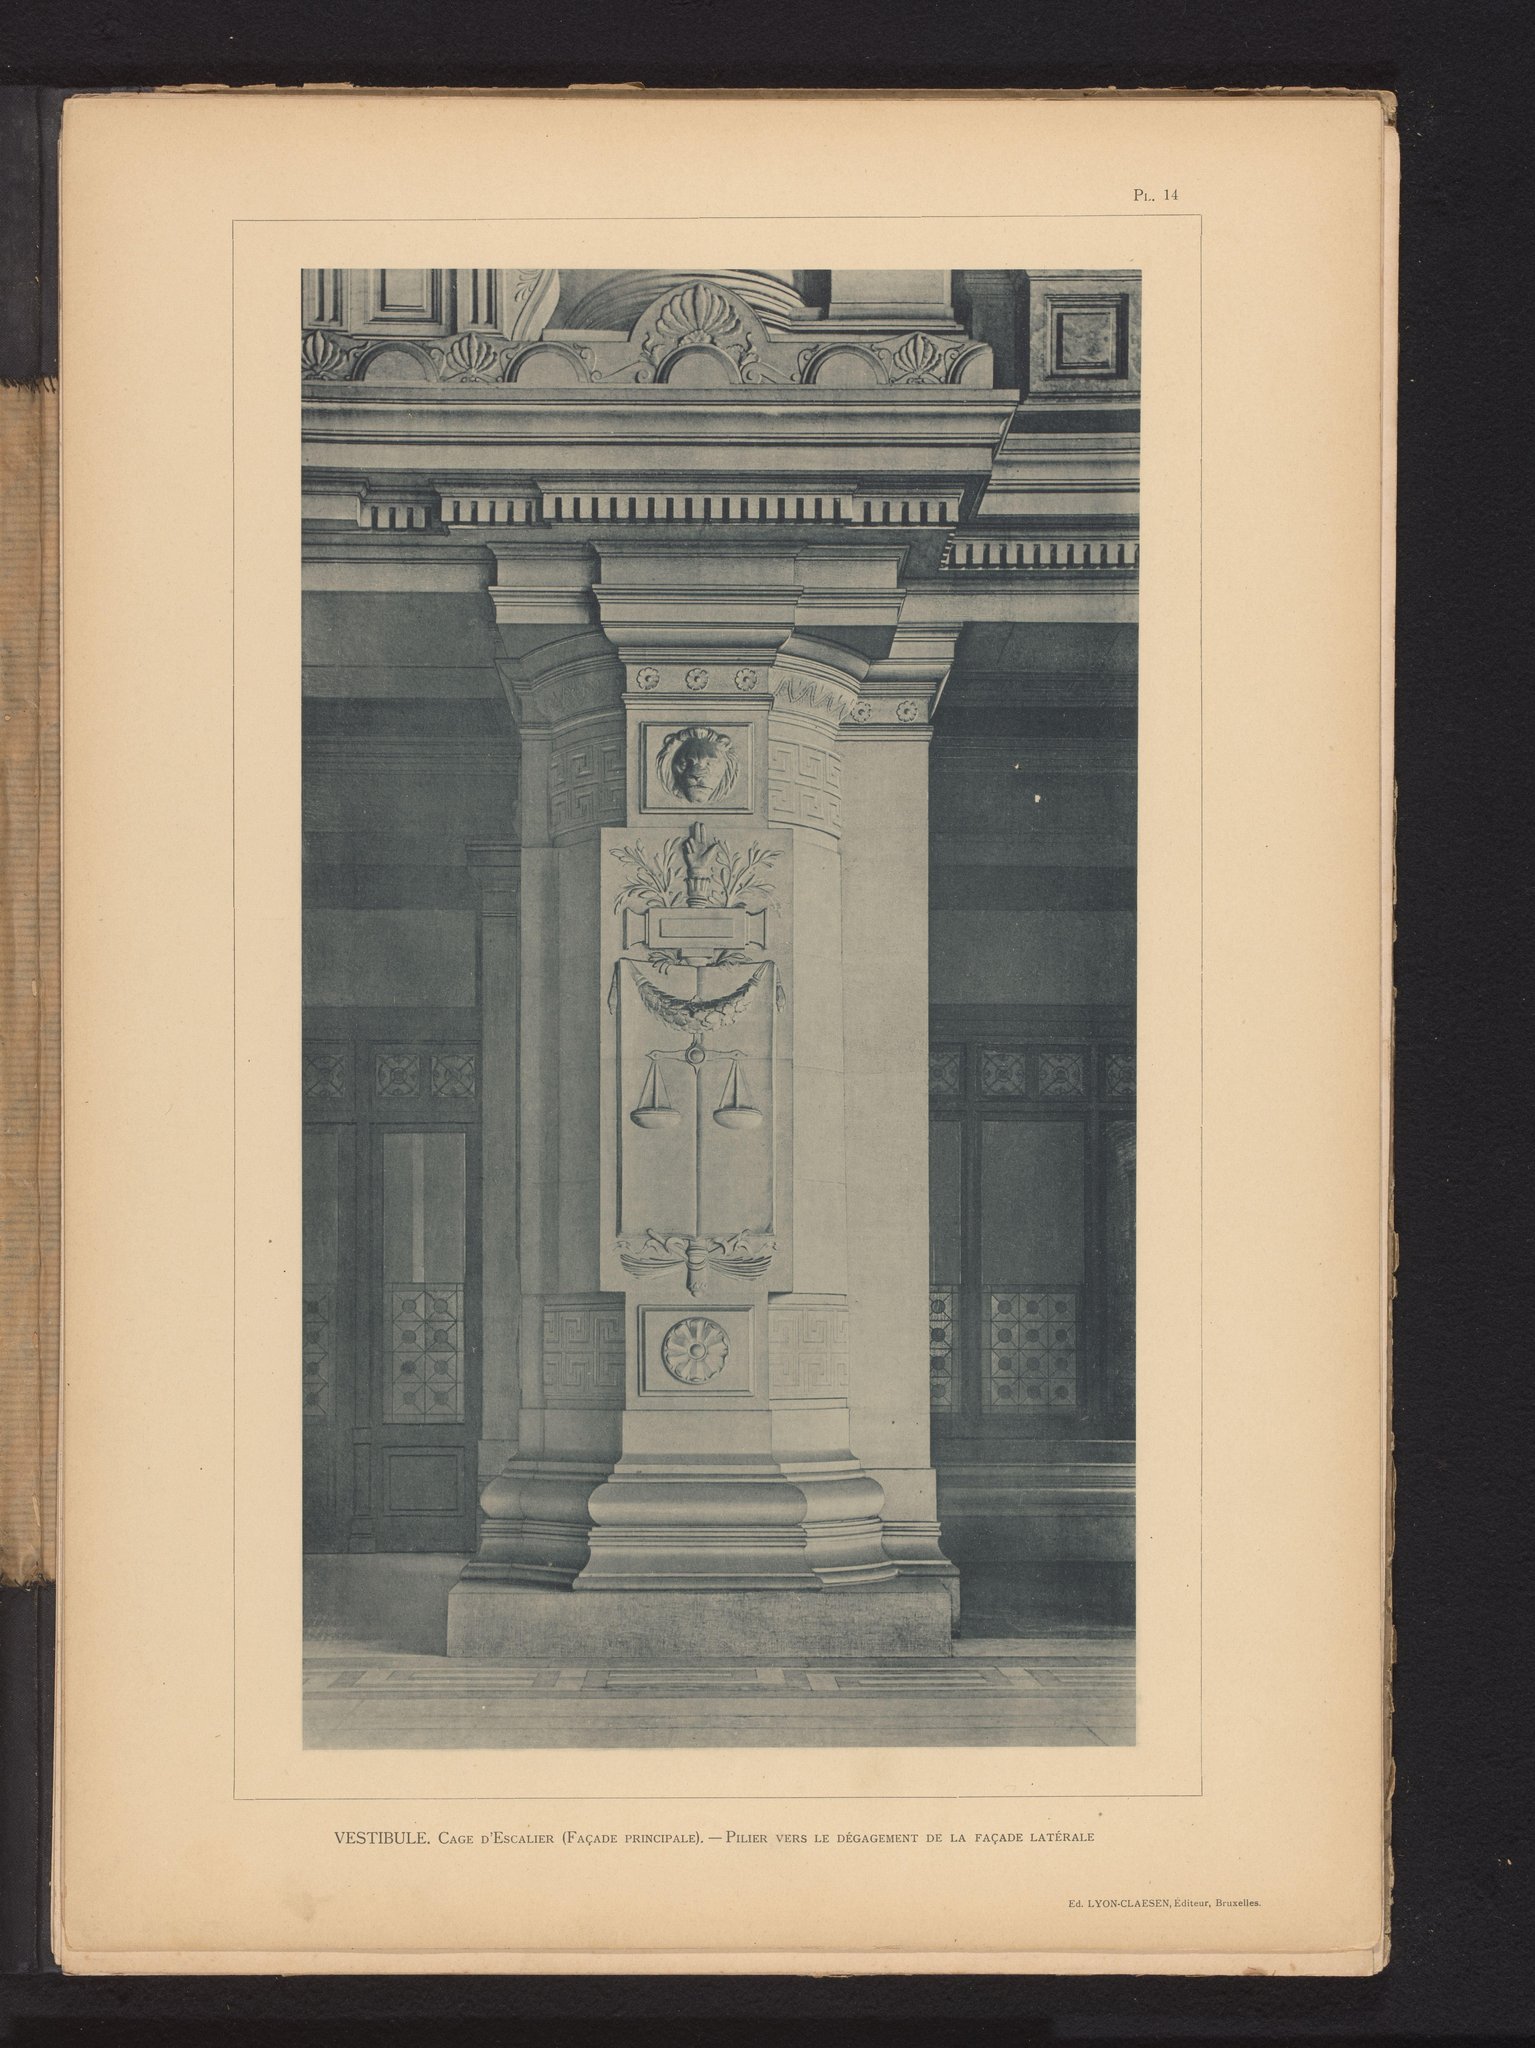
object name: photomechanical print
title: Vestibule. Cage d'Escalier (Façade Principale). - Pilier vers le Dégagement de la Façade Latérale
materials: paper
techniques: photograph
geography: brussels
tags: court building, justice, 'justitia'; 'giustitia divina' (ripa) ~ one of the four cardinal virtues, column, pillar ~ architecture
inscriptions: number: ‘PL. 14’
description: Deze prent maakt deel uit van een omslag met 30 prenten op 28 bladen en een titelblad.